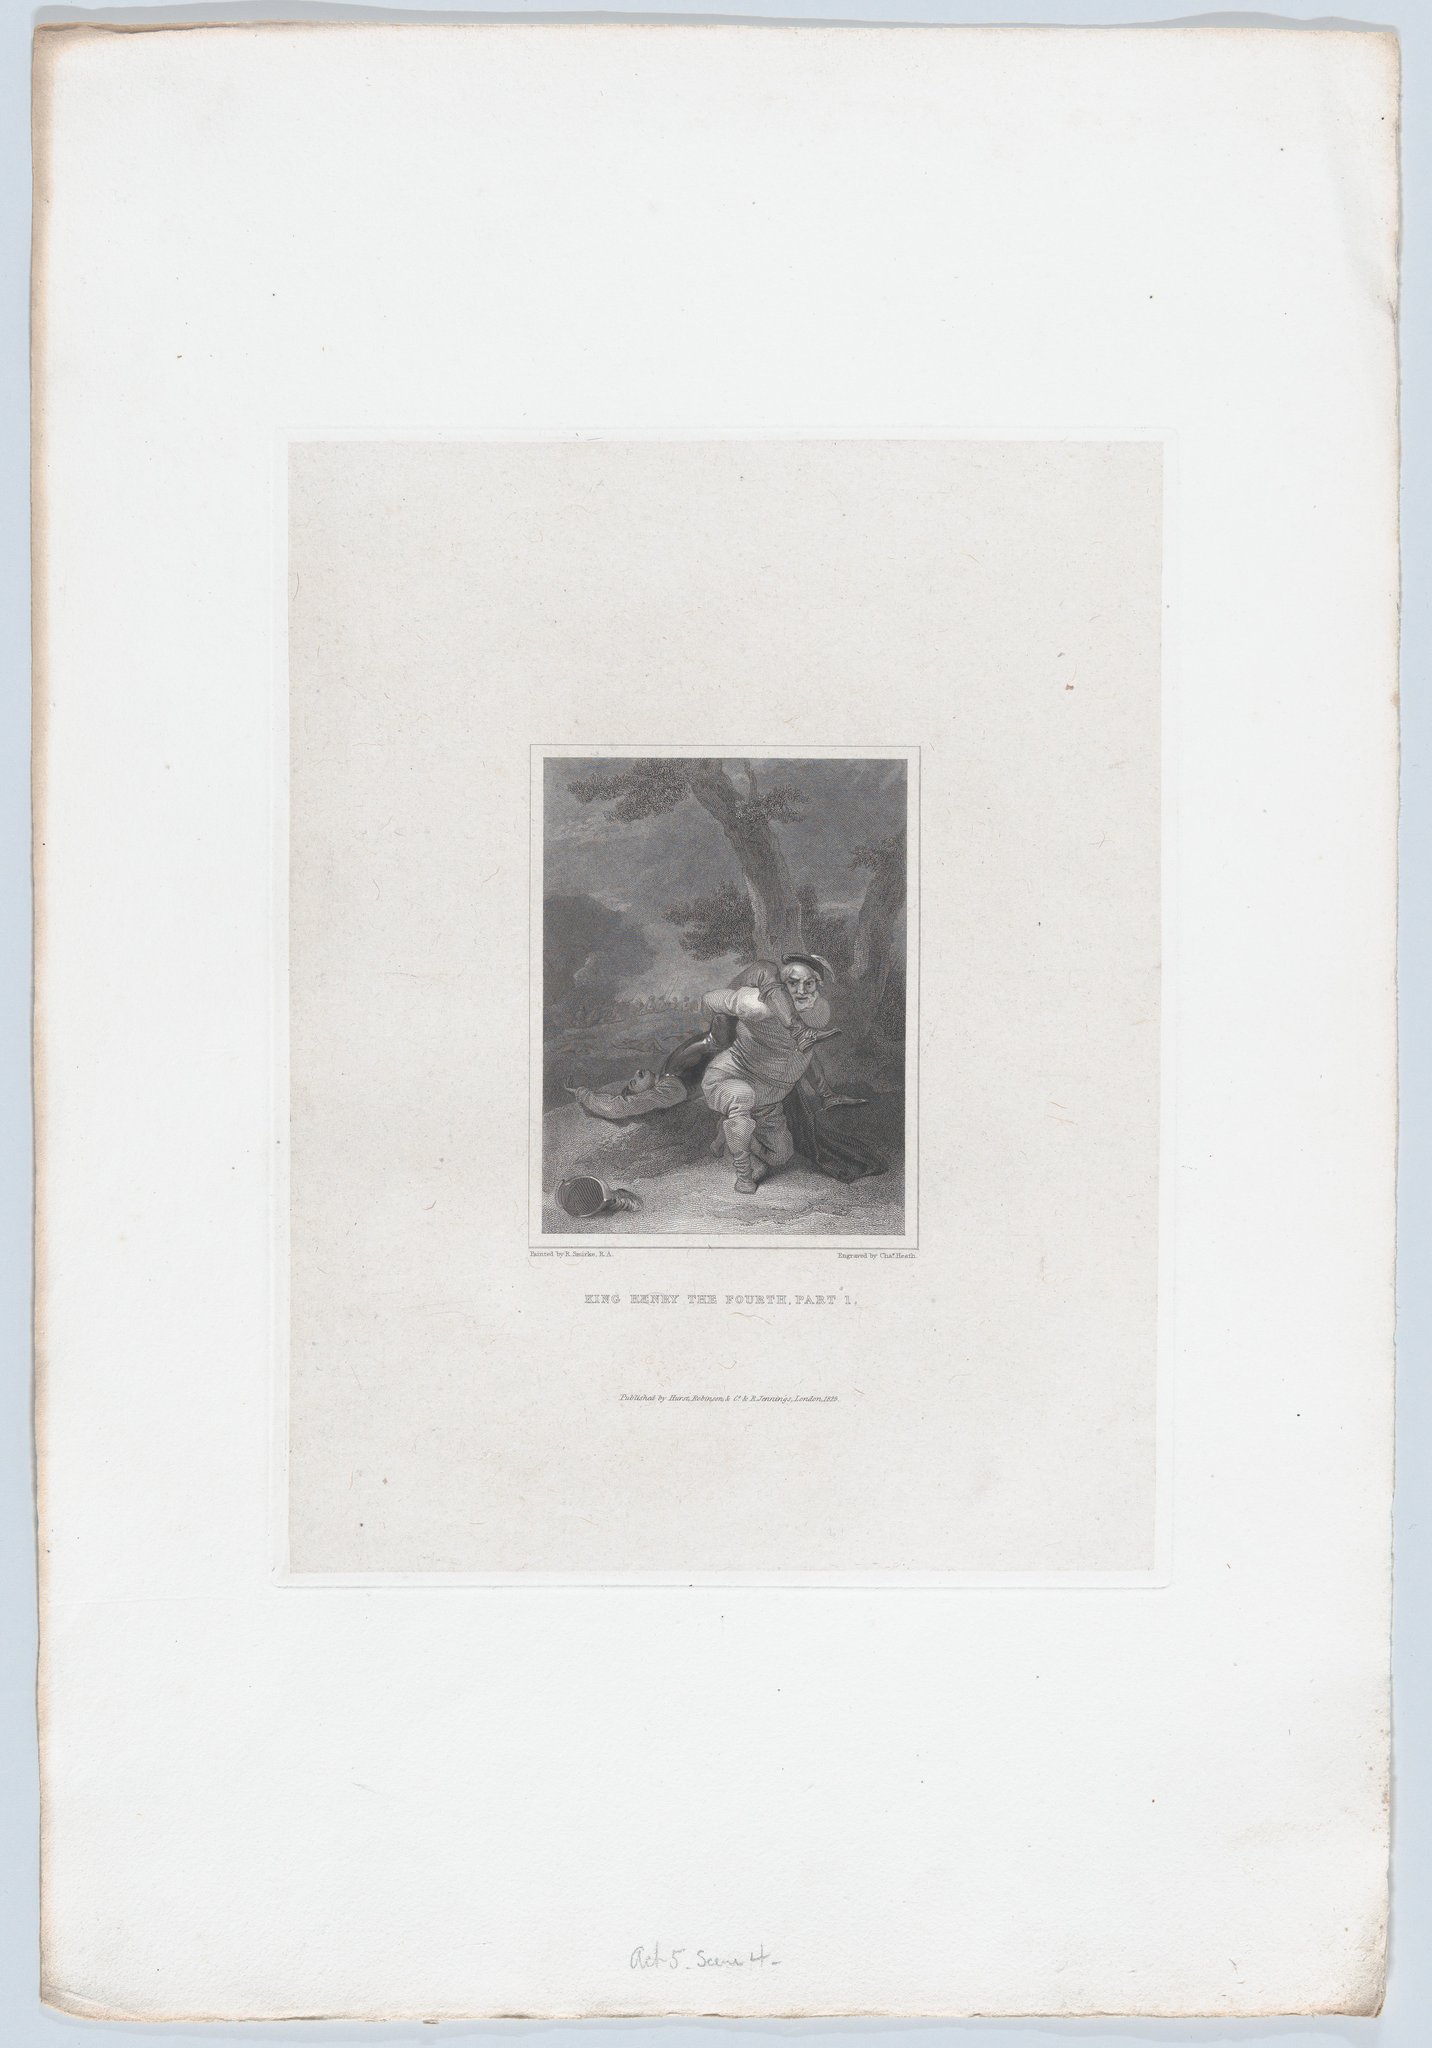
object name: print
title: Falstaff on the Battlefield (Shakespeare, King Henry IV, Part I, Act 5, Scene 4)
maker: charles heath, the elder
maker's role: engraver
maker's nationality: british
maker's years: 1785-1848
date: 1825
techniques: printmaking, engraving, etching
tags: shakespeare,men